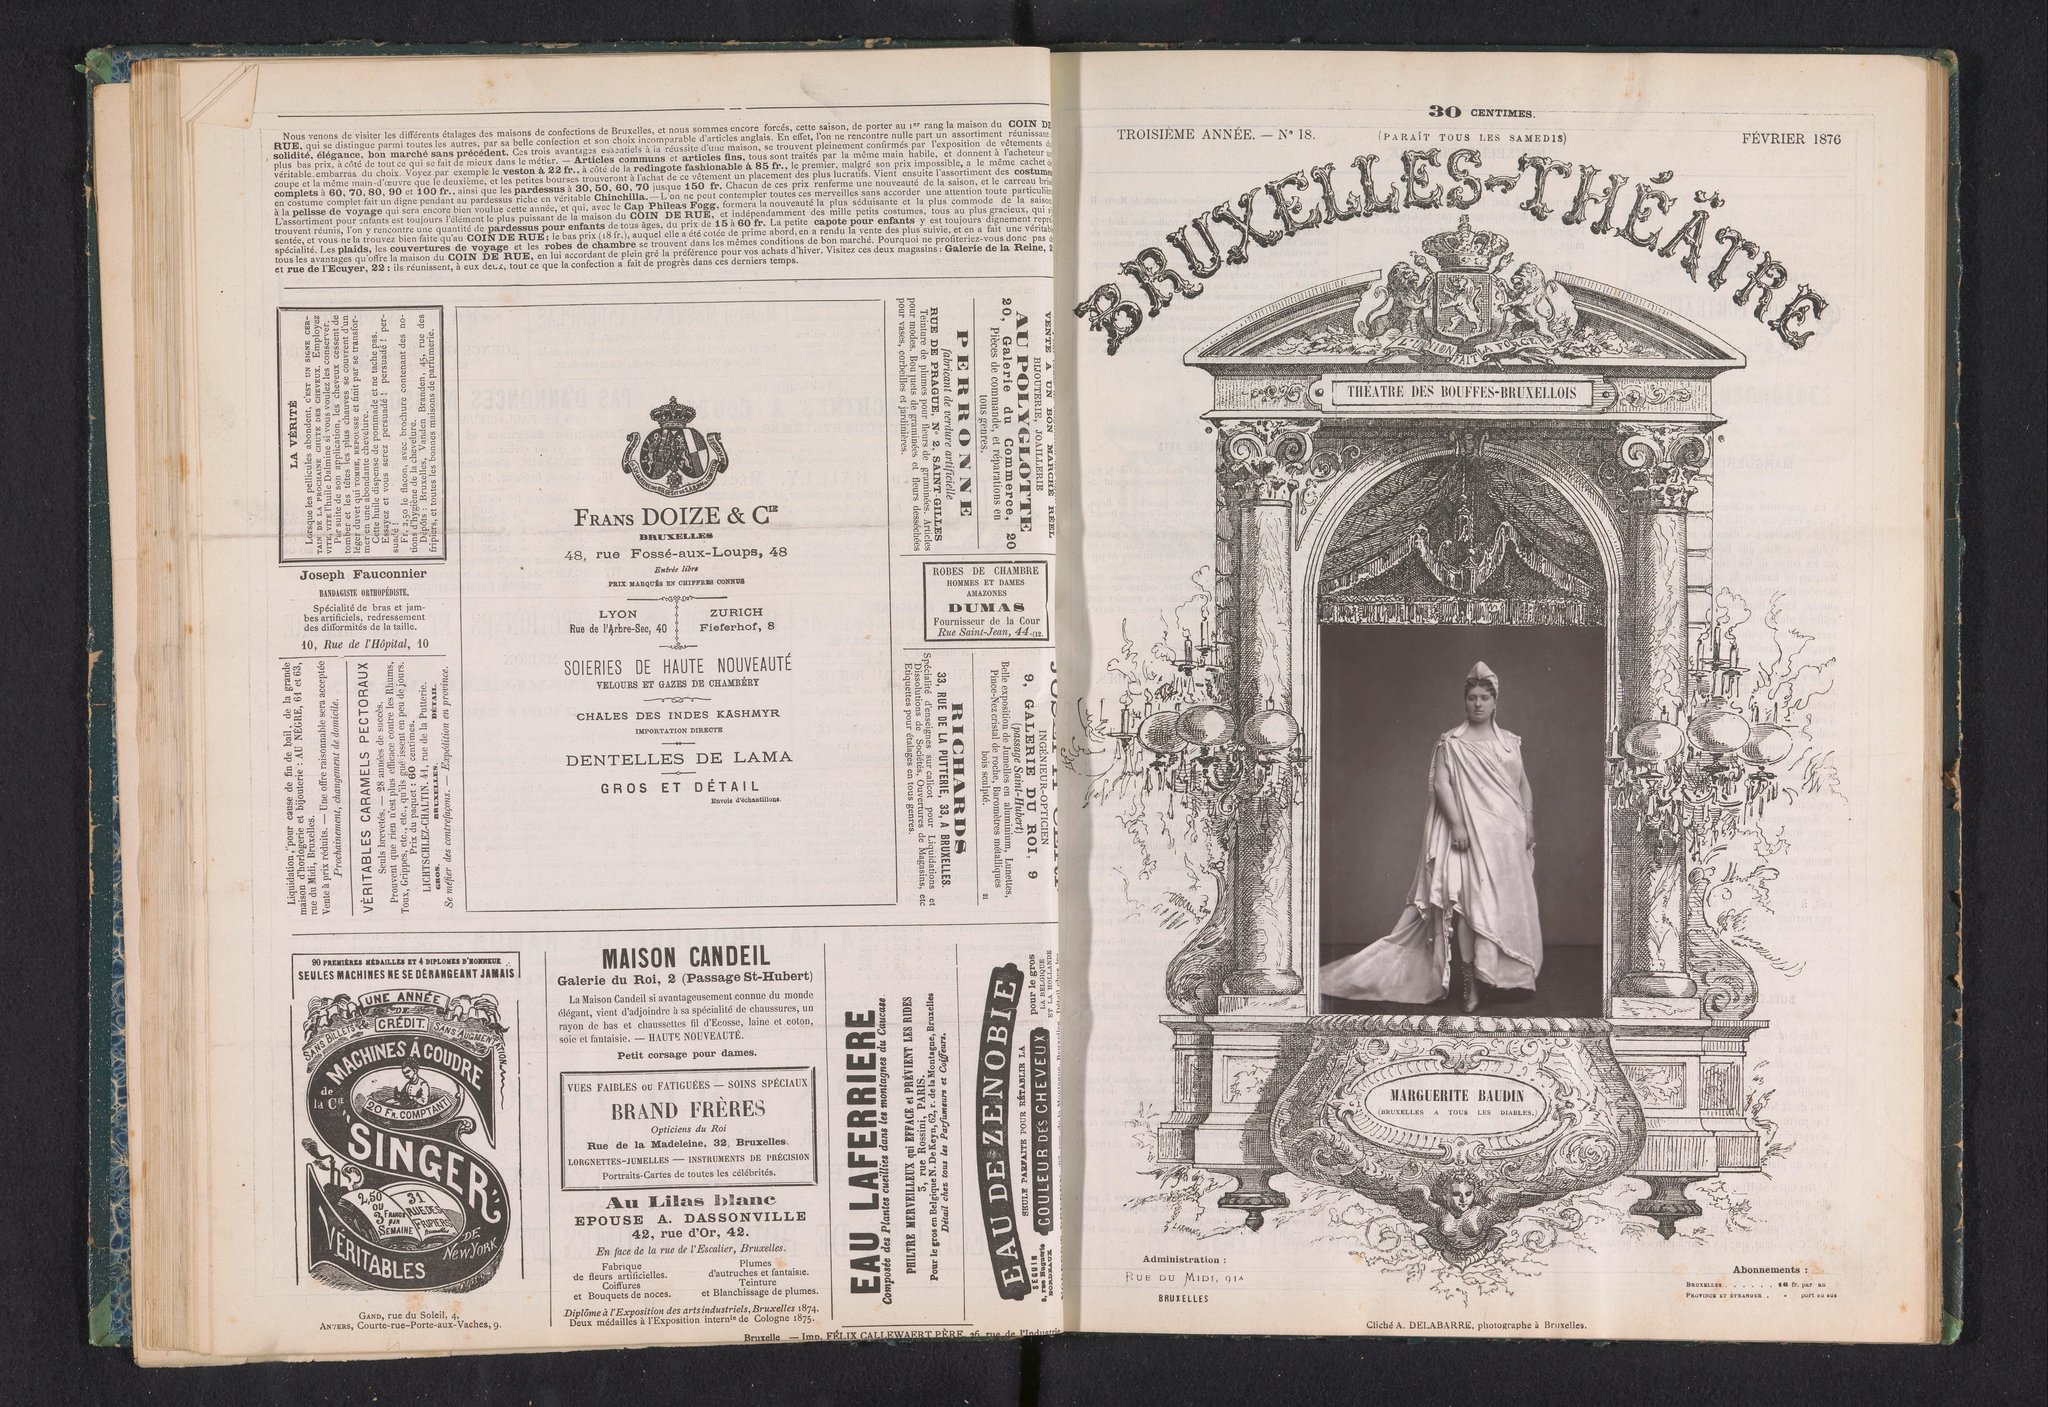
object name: page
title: Portret van Marguerite Baudin in Bruxelles à tous les diables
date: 1871-1876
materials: paper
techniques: woodburytype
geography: brussels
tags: portrait of actor, actress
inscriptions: number: ‘No 18.’